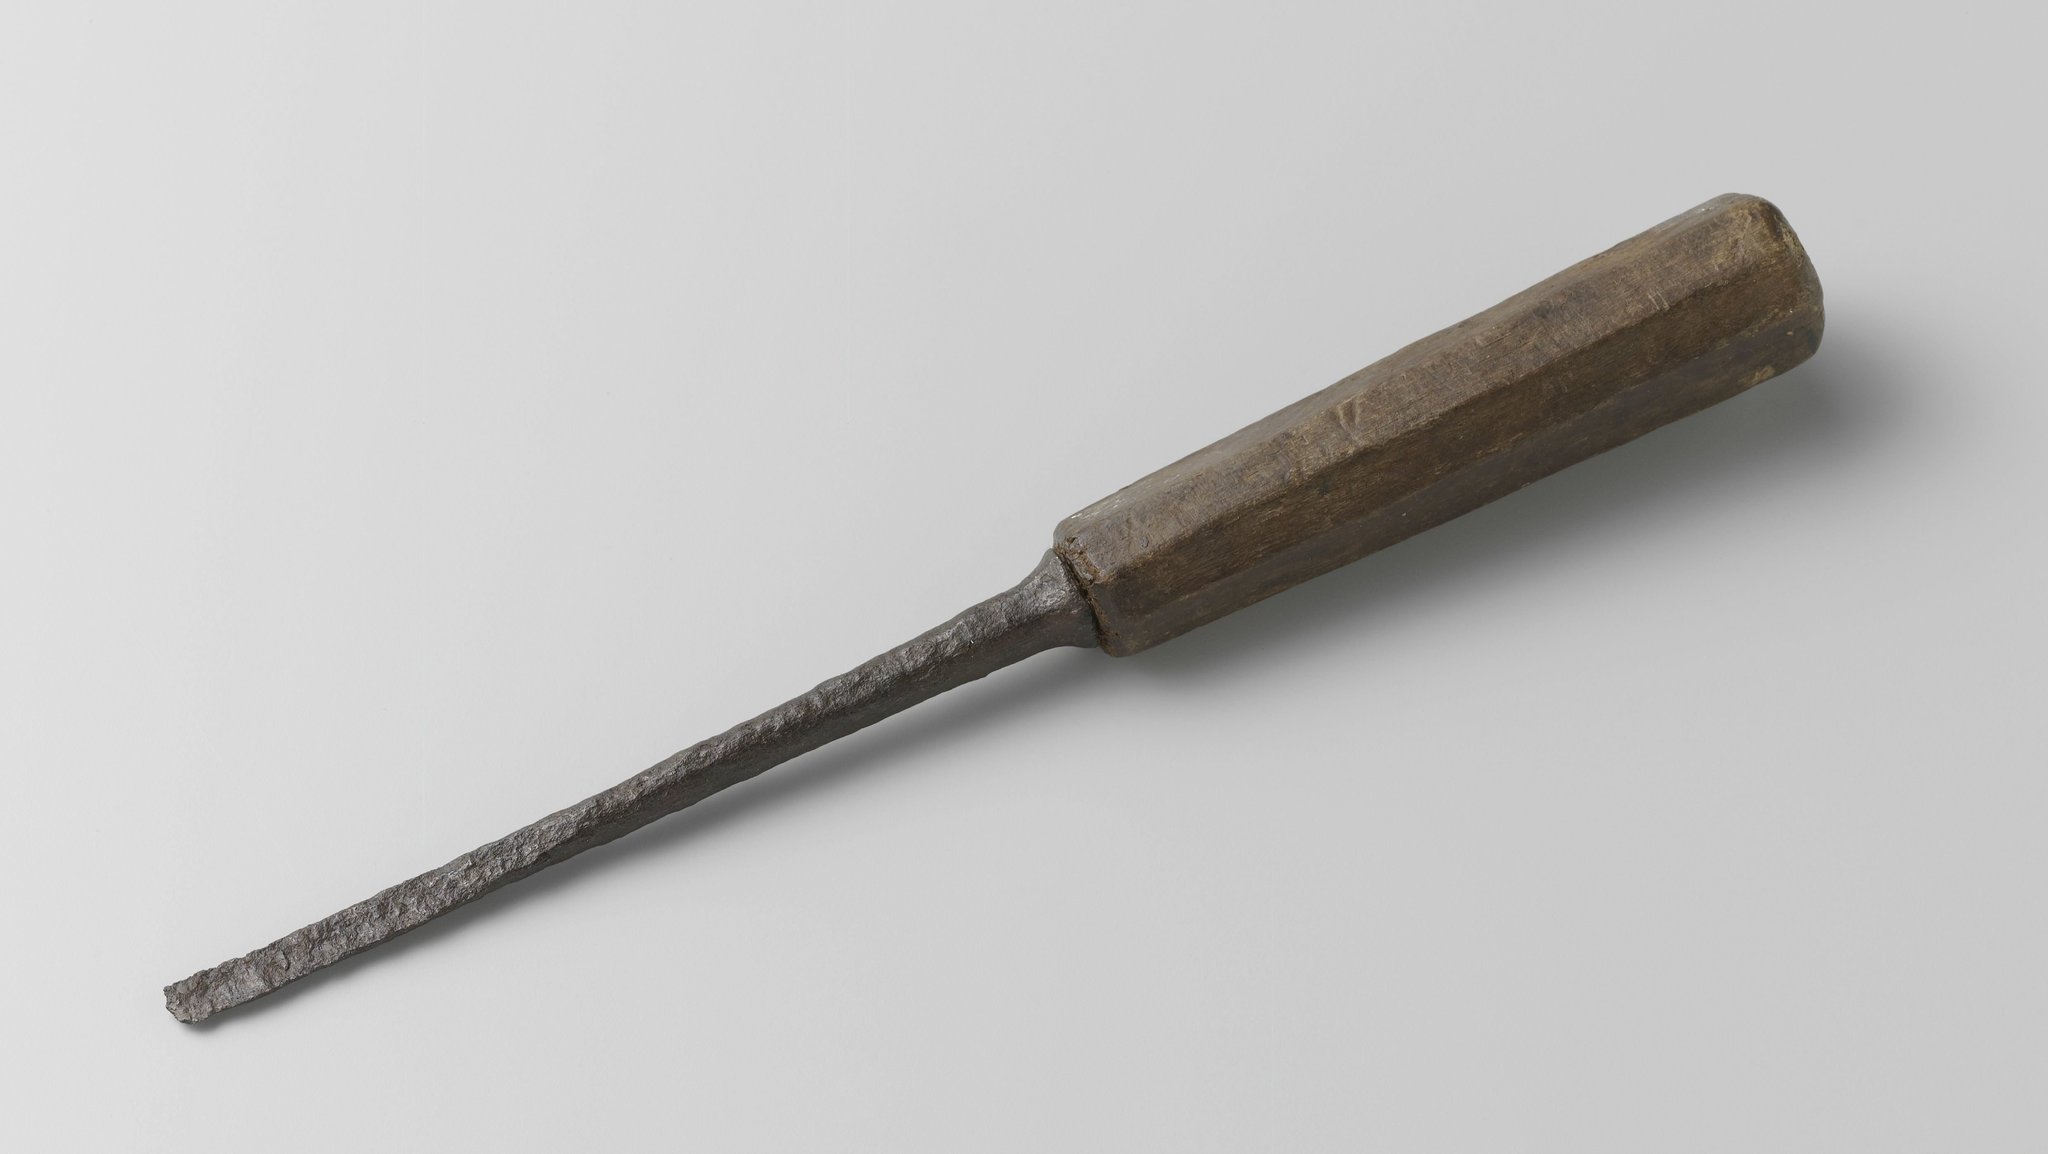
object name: paring chisel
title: Steekbeitel met octogonaal handvat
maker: Anonymous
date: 1590-1596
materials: iron, wood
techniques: cutting, forging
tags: willem barendsz., amsterdam, jacob van heemskerck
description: Paring chisel